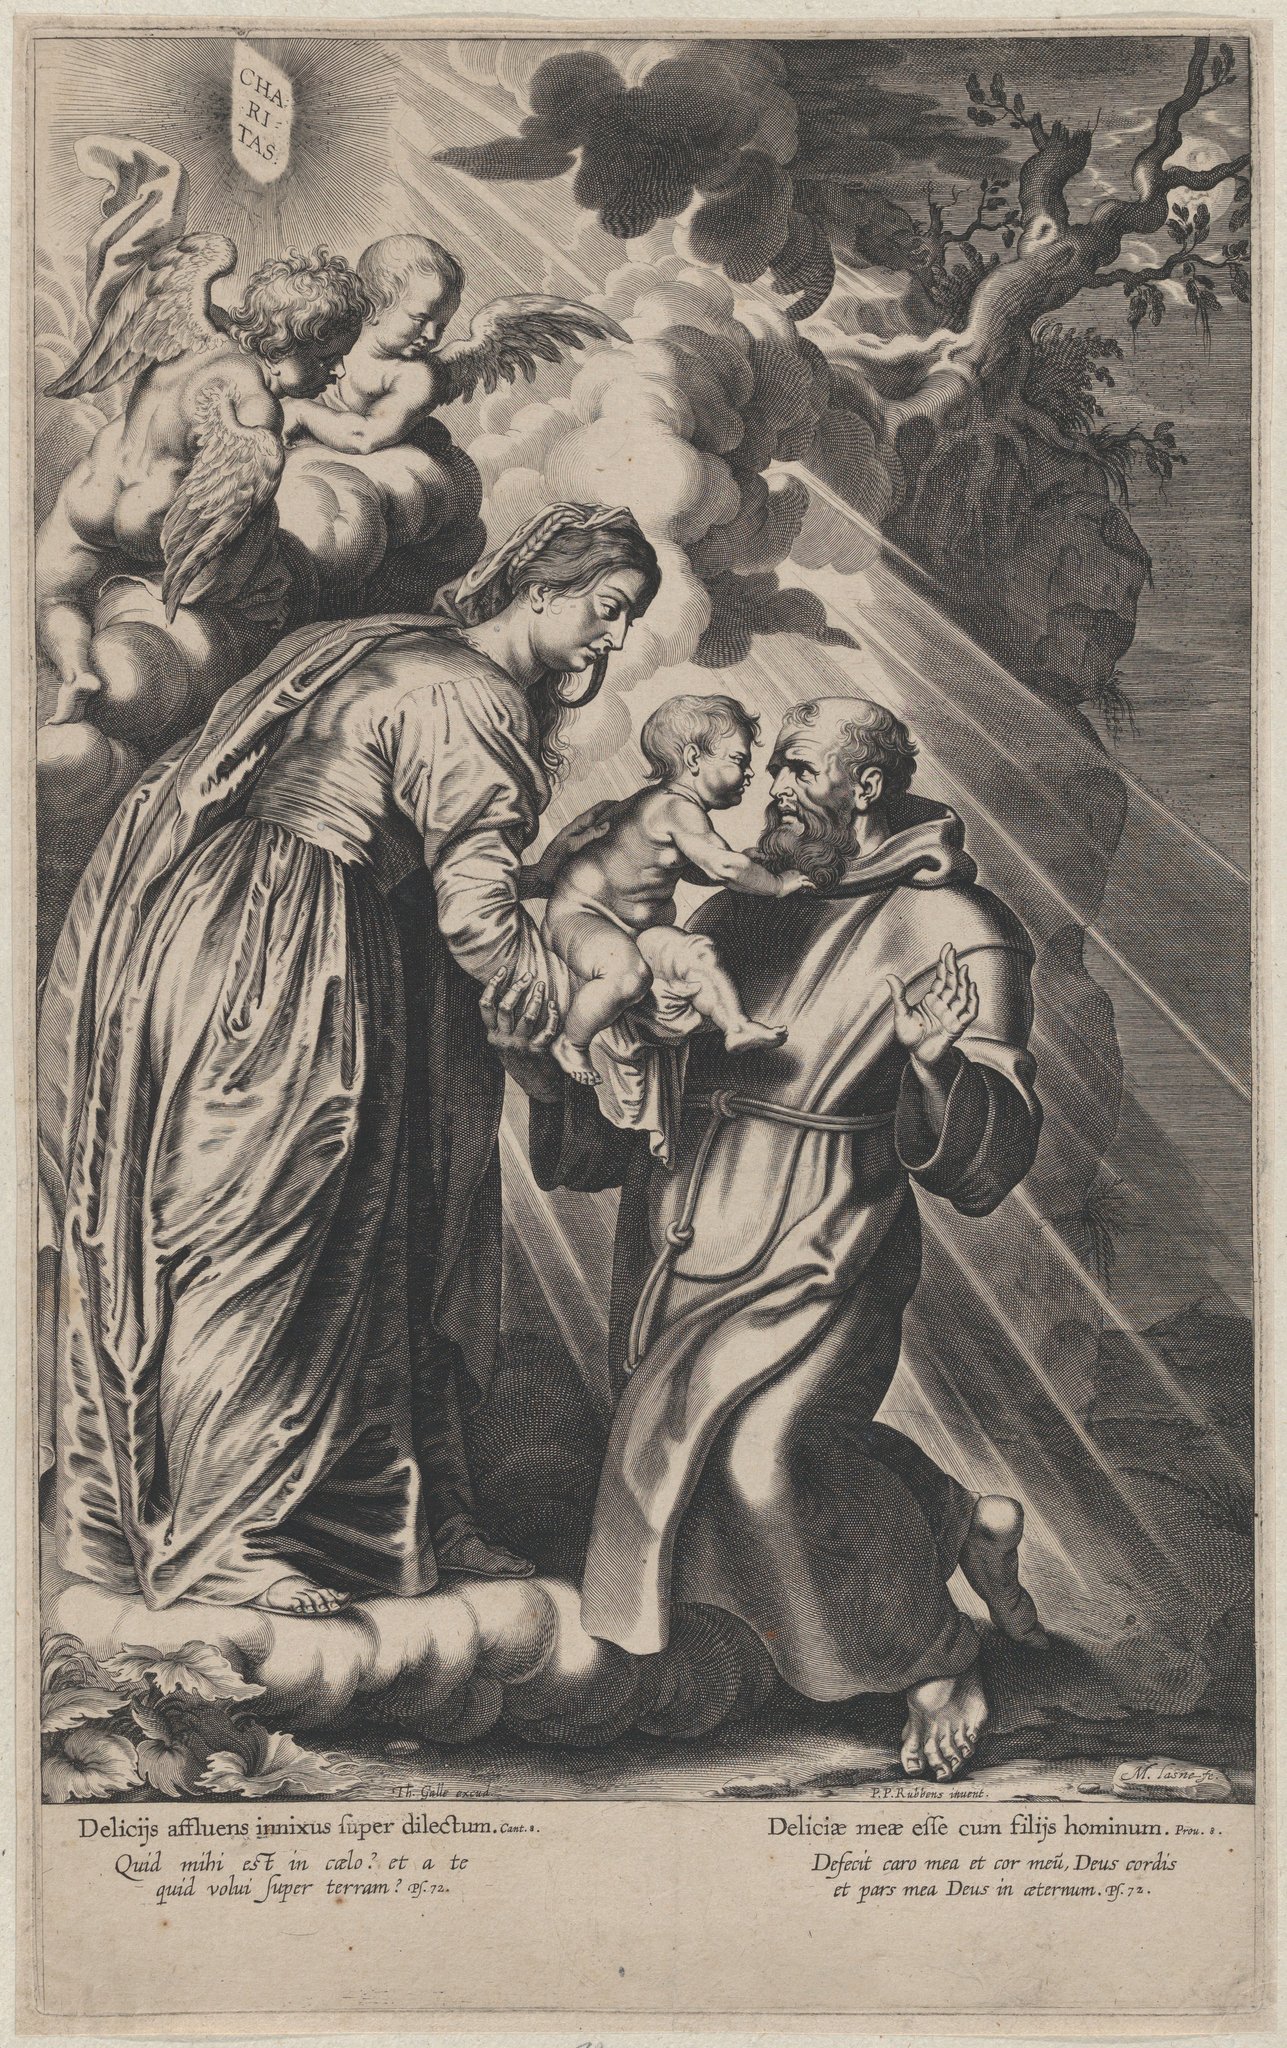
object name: print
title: The Vision of Saint Francis, kneeling at right, receiving the Christ child from the Virgin Mary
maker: michel lasne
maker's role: artist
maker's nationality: french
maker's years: 1590-1667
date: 1617-1620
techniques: engraving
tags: angels,madonna and child,saint francis